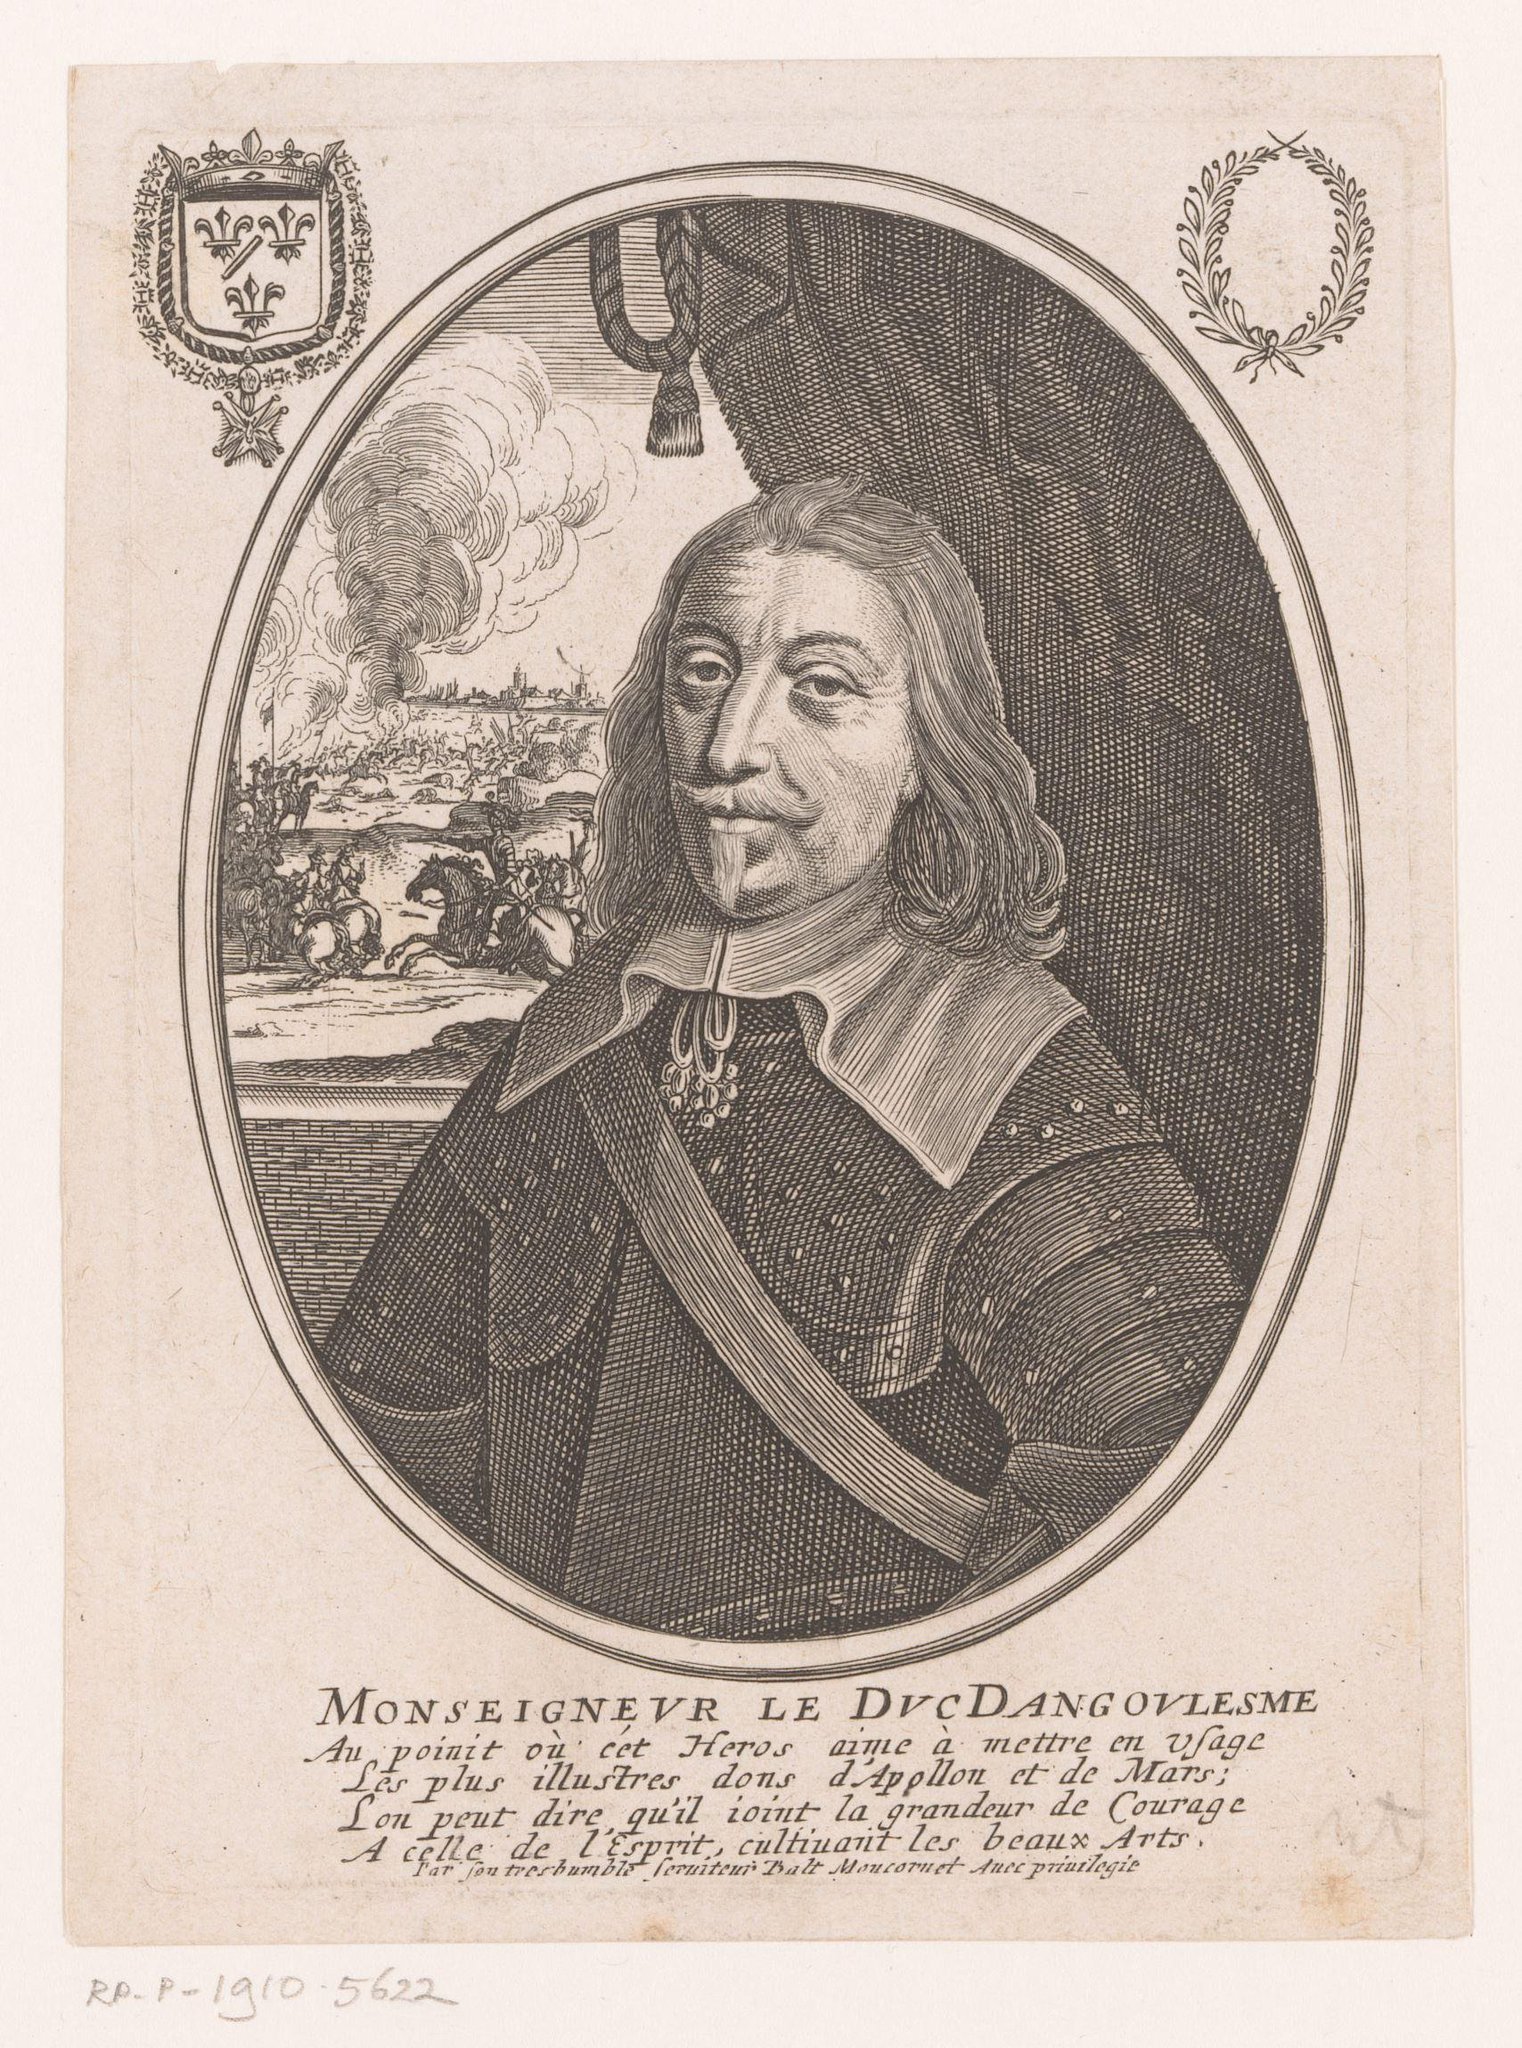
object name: print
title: Portret van Charles d'Angoulême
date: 1659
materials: paper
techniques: engraving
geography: paris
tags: charles de valois (hertog van angoulême), historical persons, armorial bearing, heraldry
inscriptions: collector's mark: Lugt 2228